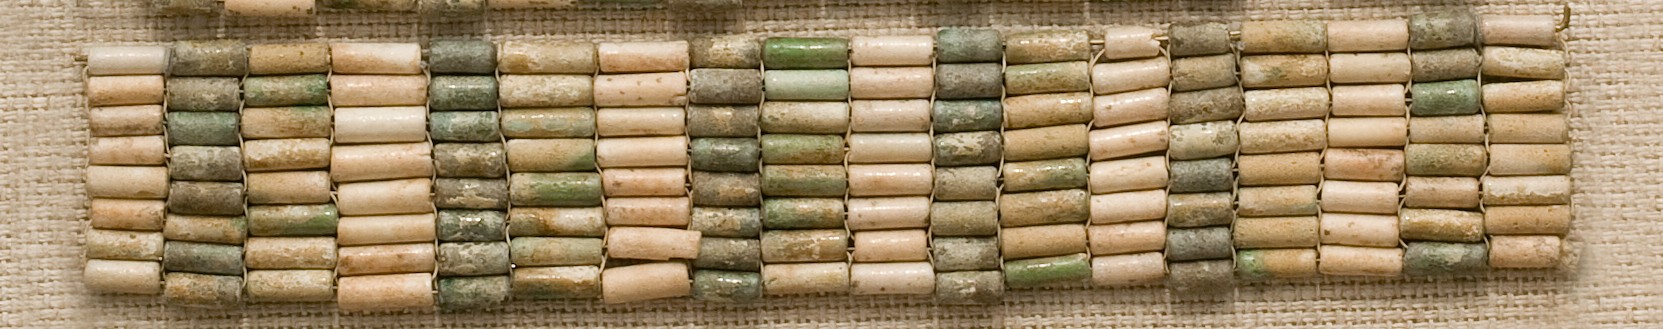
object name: bracelet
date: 1981-1640 BCE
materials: faience, paste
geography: egypt